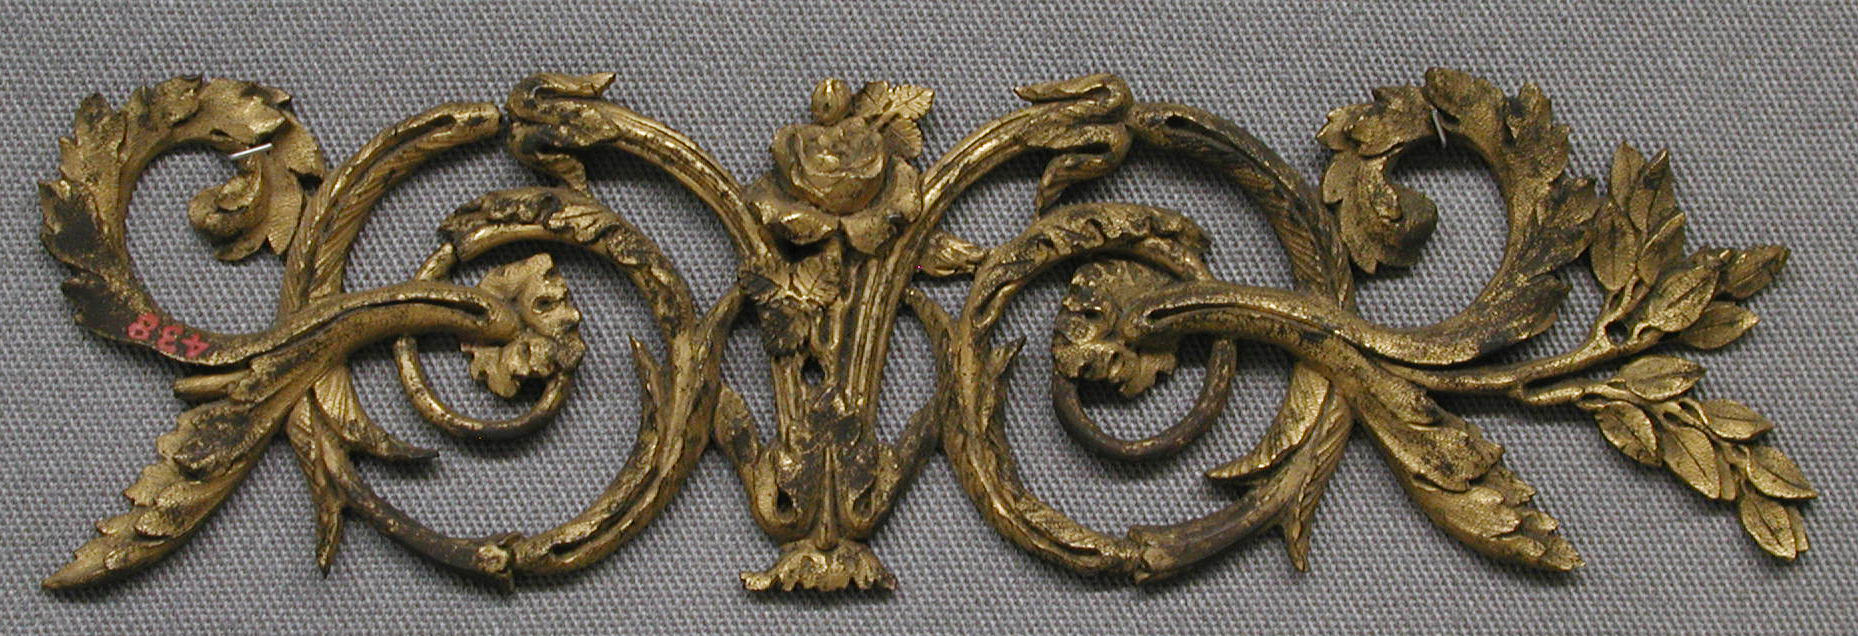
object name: frieze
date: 1701-1800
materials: gilt bronze